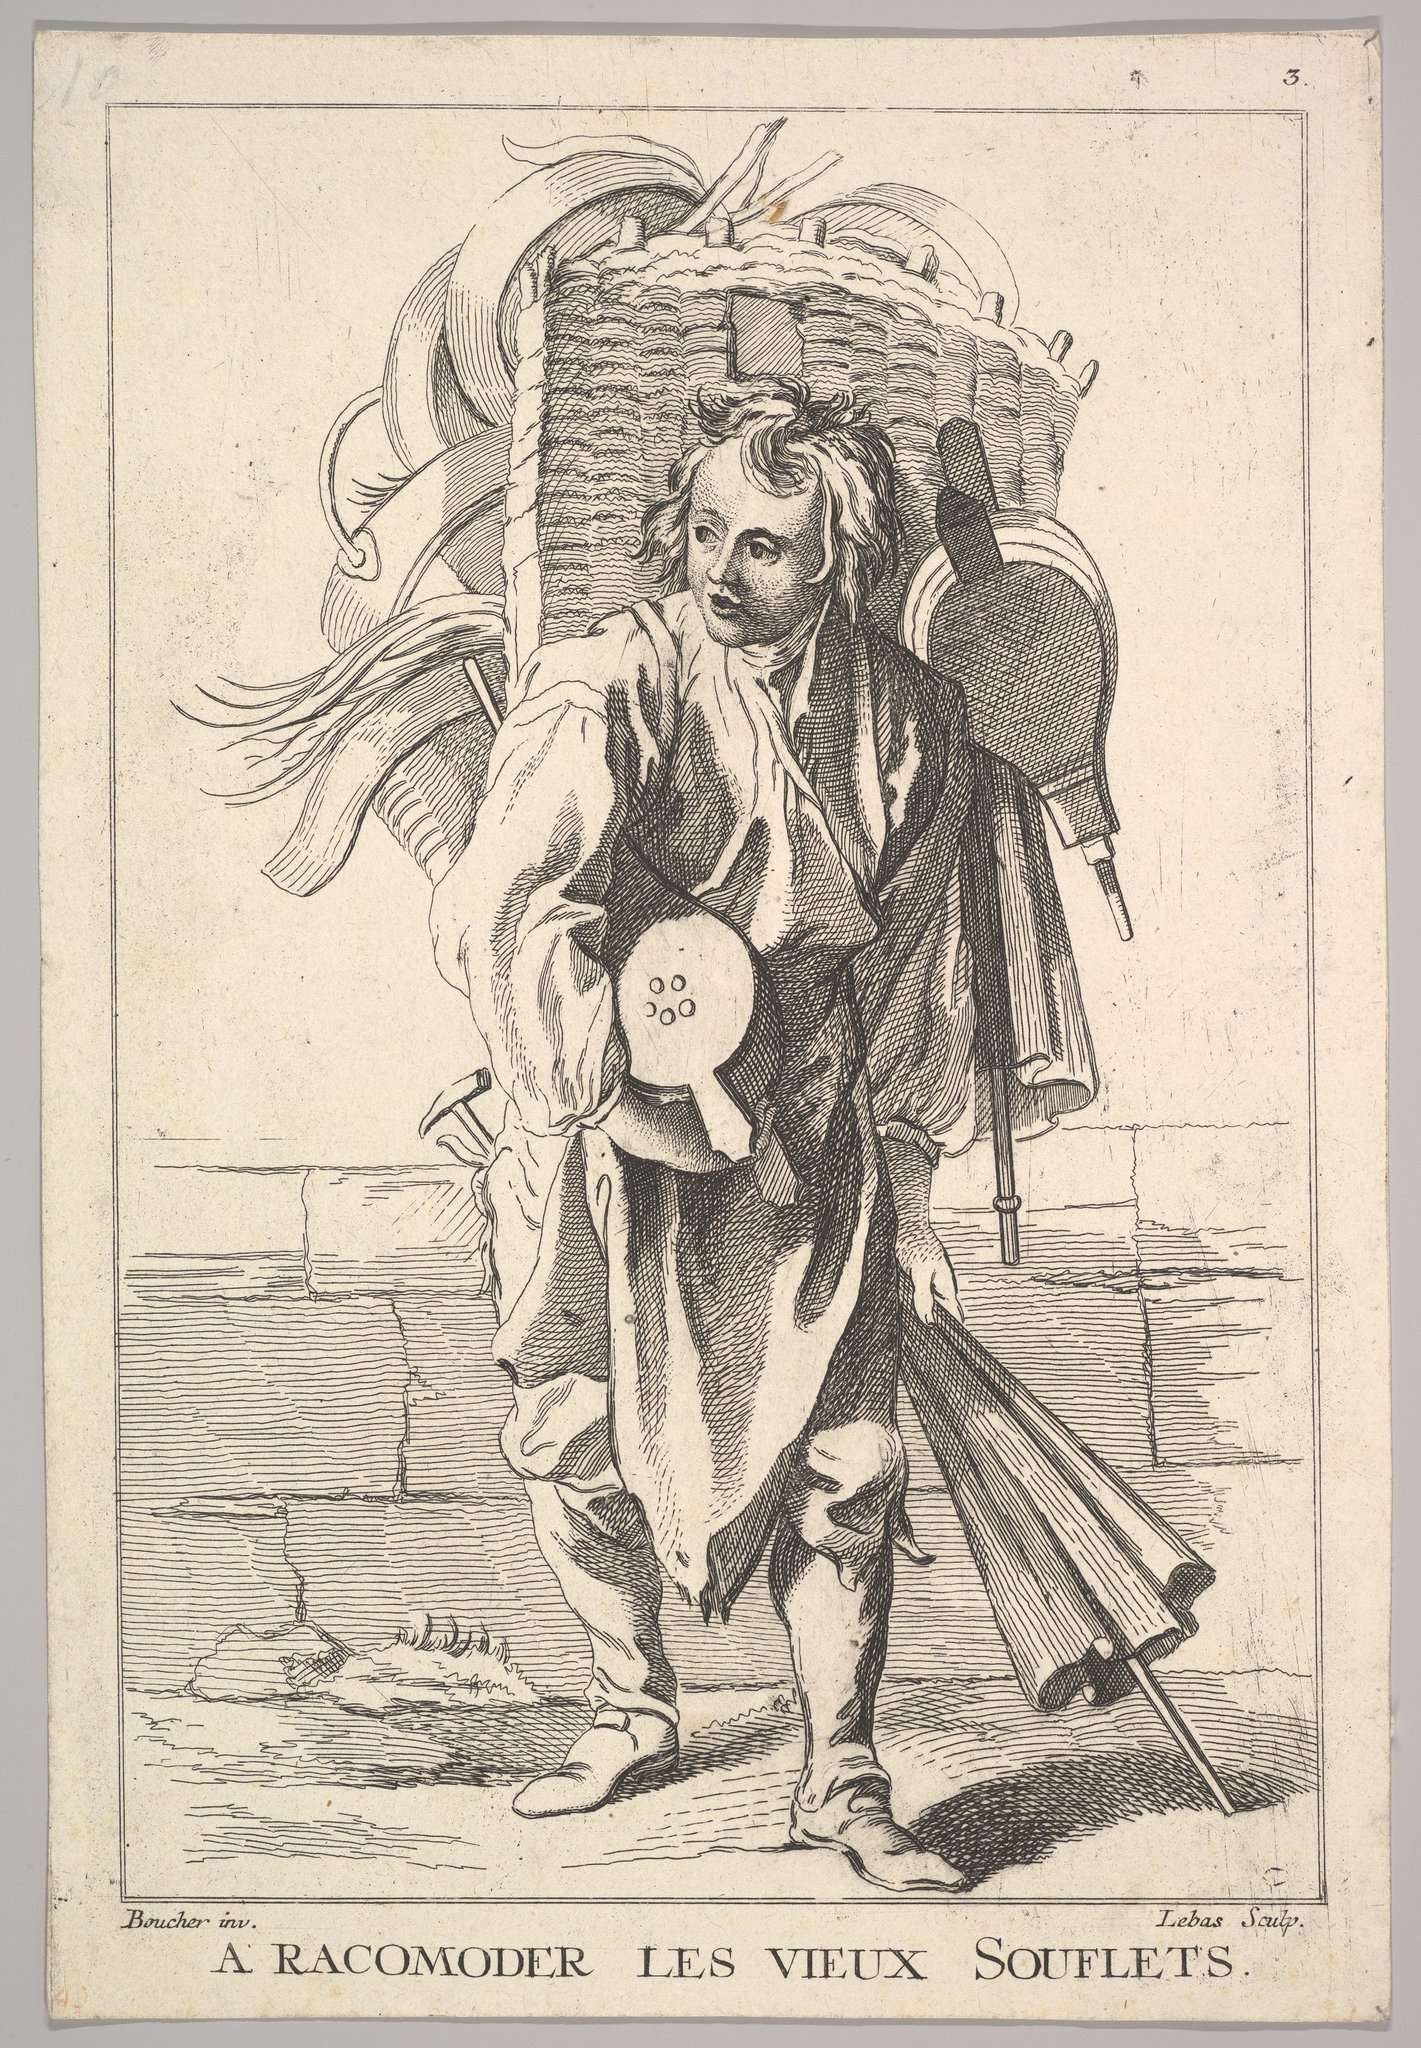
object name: print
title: Reverse copy of A Racomoder les Vieux Souflets (Mend the Old Bellows), plate 3 from "Le Cris de Paris" (The Cries of Paris)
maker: jacques philippe le bas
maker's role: artist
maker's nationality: french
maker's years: 1707-1783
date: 1701-1800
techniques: engraving, etching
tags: men,bellows